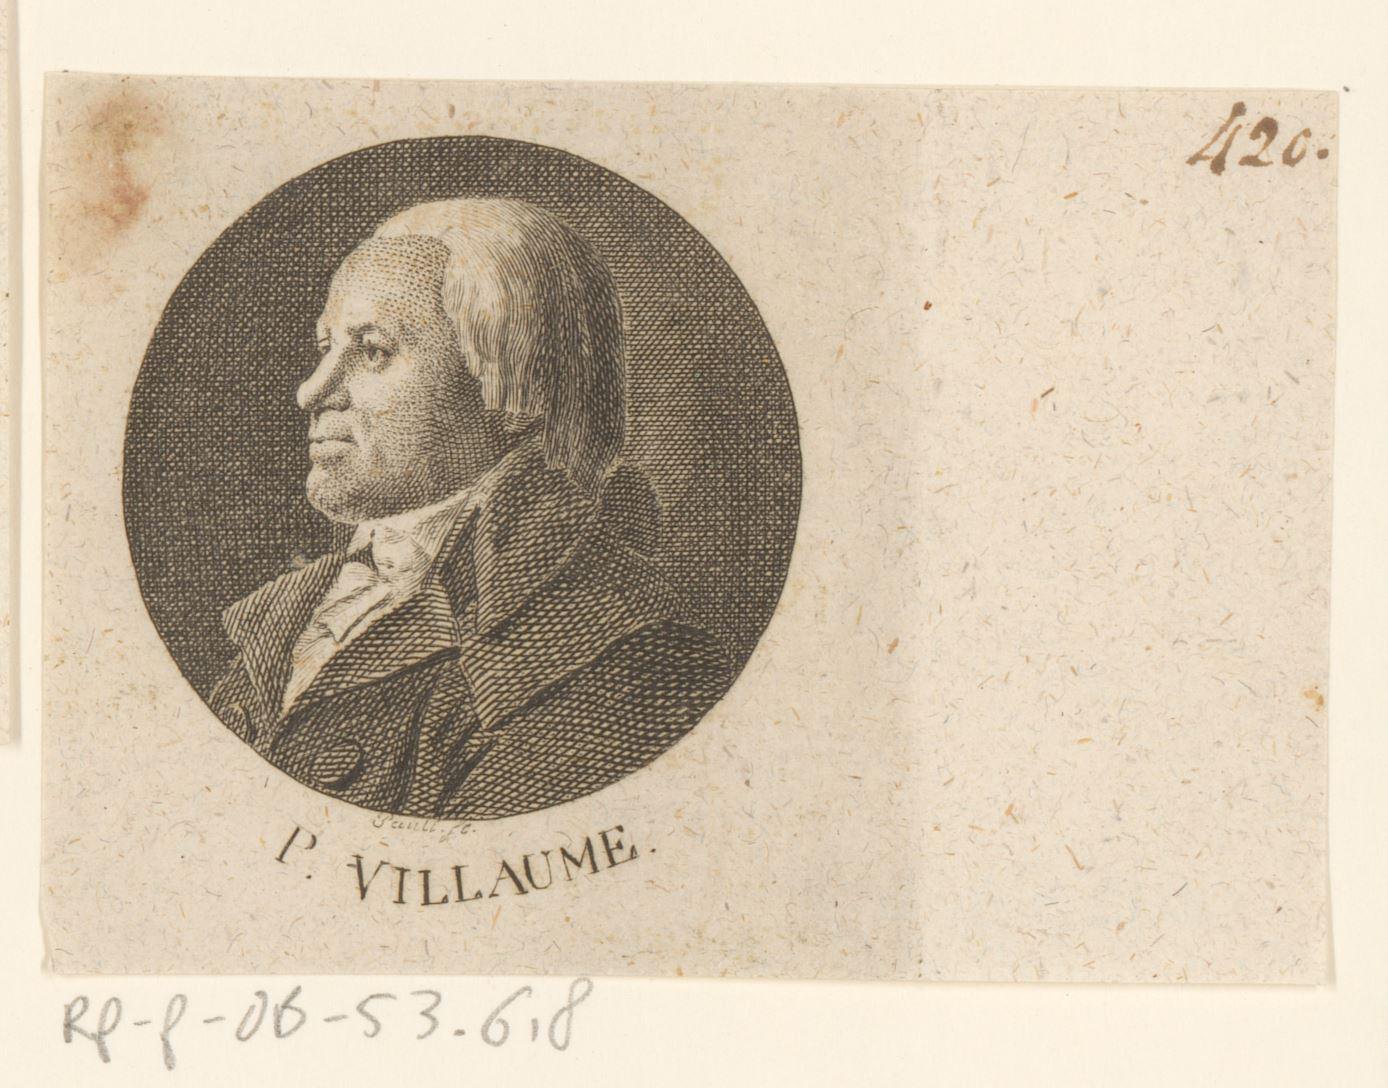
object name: print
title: Portret van Peter Villaume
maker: jan willem paulus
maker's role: print maker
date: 1761-1849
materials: paper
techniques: engraving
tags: berlin, historical persons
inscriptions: number: ‘420.’